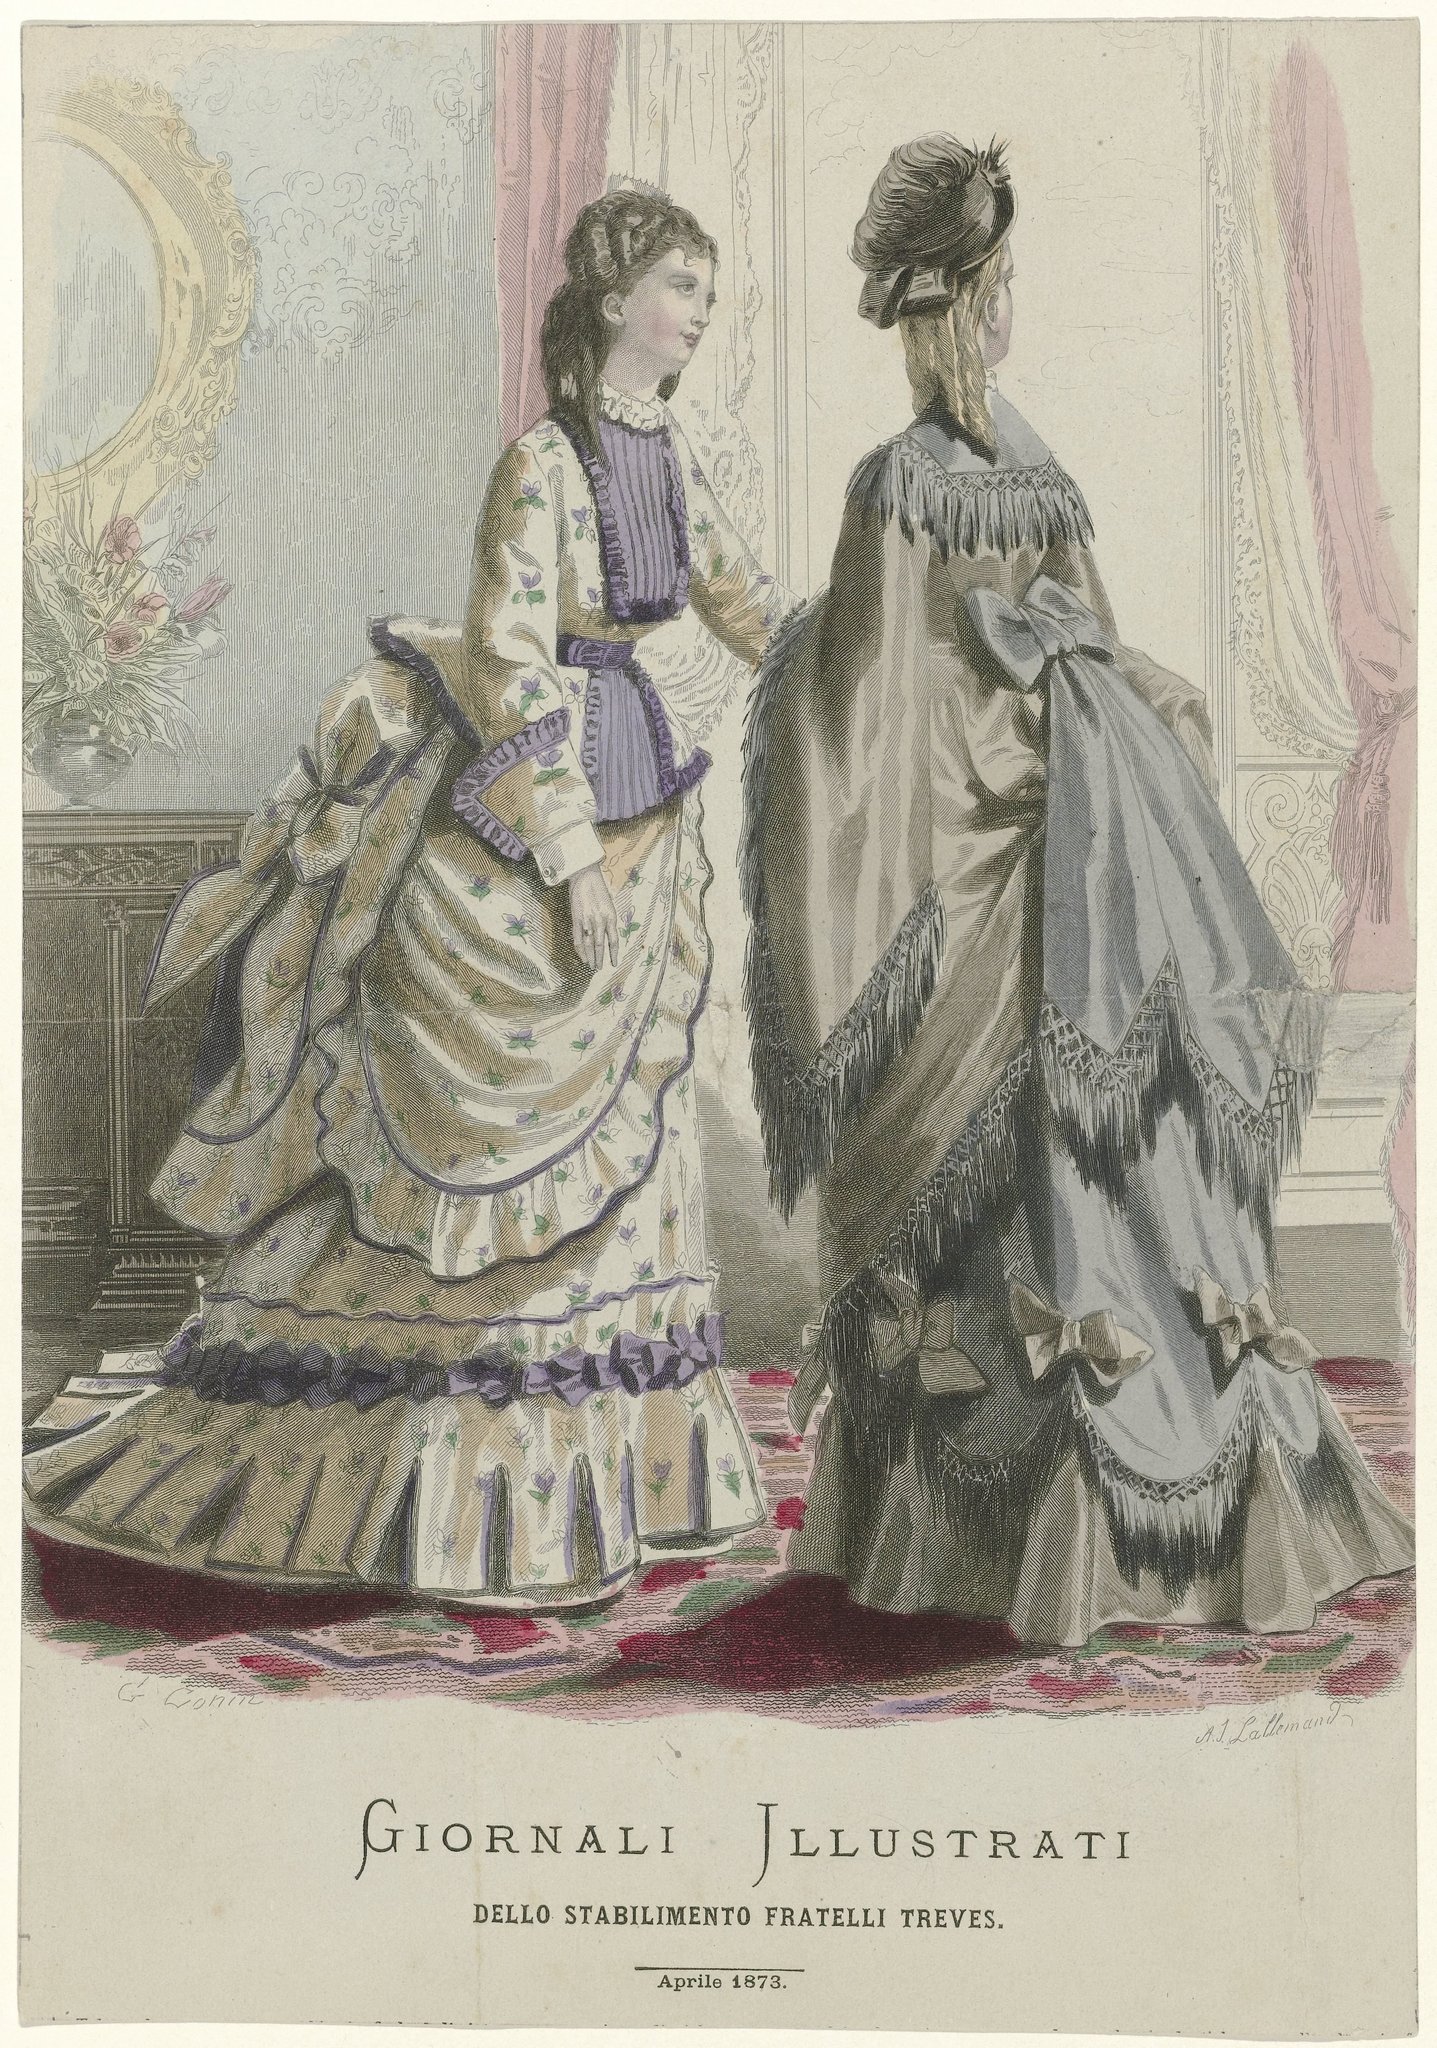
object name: fashion print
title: Giornali Illustrati, Dello Stabilimento Fratelli treves, Aprile 1873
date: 1873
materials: paper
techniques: engraving, hand coloring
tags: head-gear (+ women's clothes), fashion plates, skirt (+ women's clothes), dress, gown (+ women's clothes)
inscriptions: title: ‘Giornali Illustrati / Dello stabilimento Fratelli Treves.’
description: Prent uit het modetijdschrift Giornali Illustrati (1864-?).